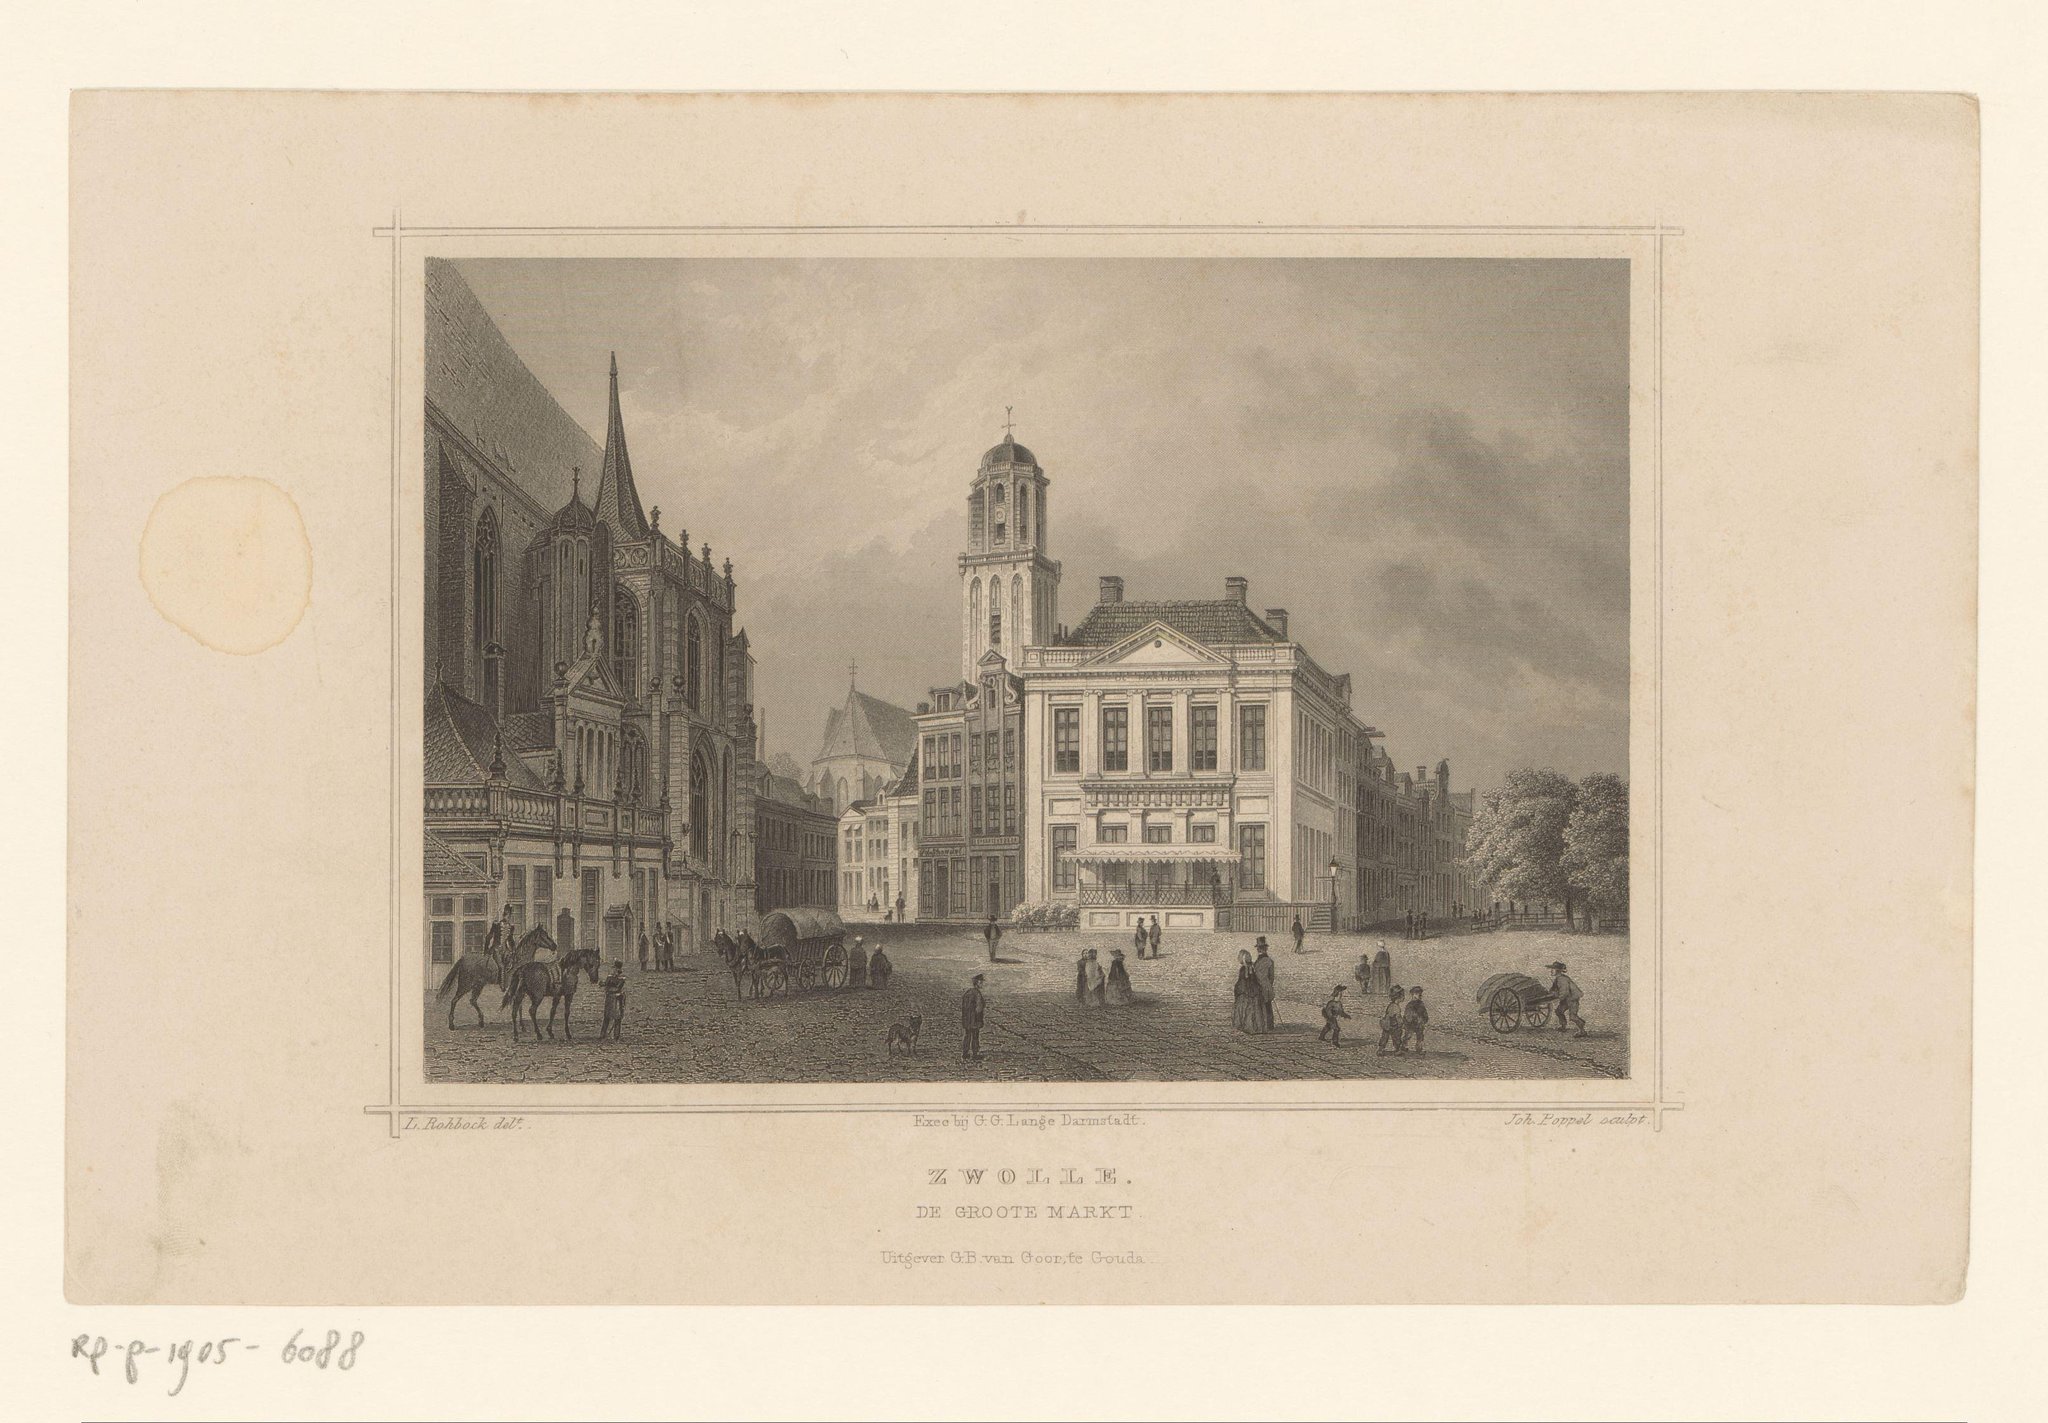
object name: print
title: Zwolle. De Groote Markt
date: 1858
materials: paper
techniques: engraving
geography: gouda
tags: city-view, and landscape with man-made constructions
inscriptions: collector's mark: Lugt 2228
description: Prent ook gebruikt in: Terwen, Johannes Leonardus. Het Koningrijk der Nederlanden voorgesteld in eene reeks van naar de natuur geteekende schilderachtige gezigten. Gouda: Van Goor, 1858-1862.